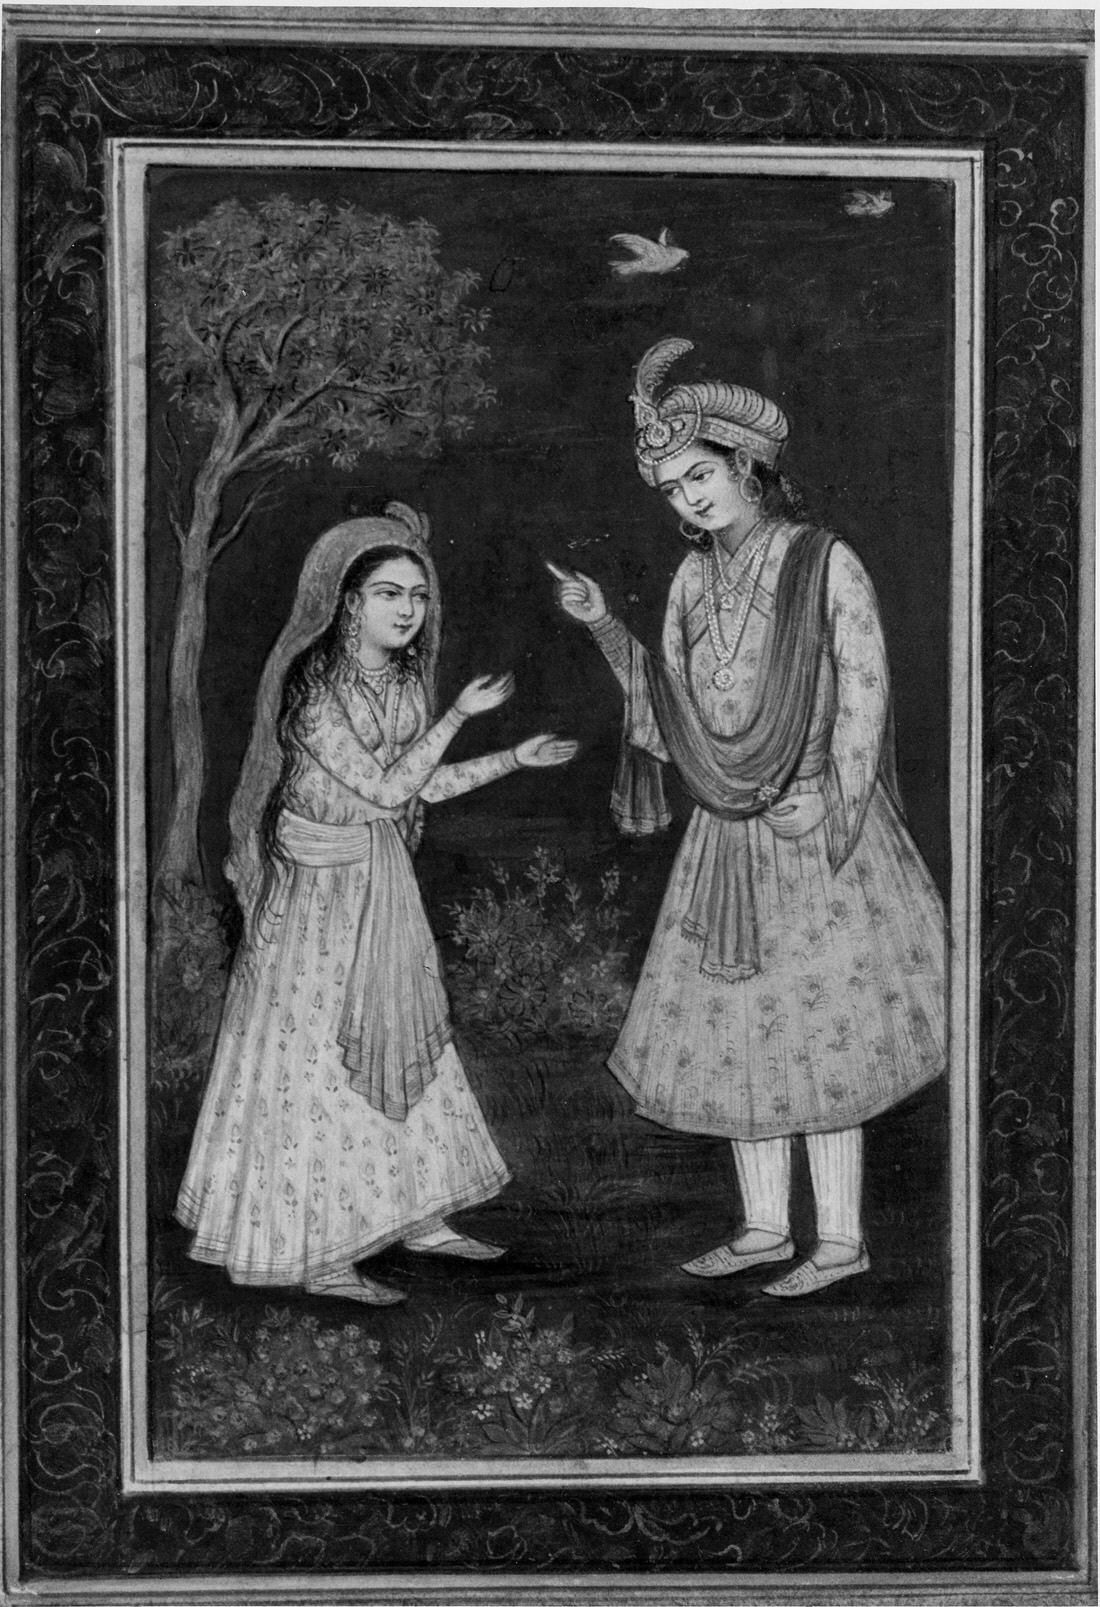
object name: album leaf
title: Royal Lovers in a Landscape Setting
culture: indian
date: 1800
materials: gold, ink, paper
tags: birds,men,women